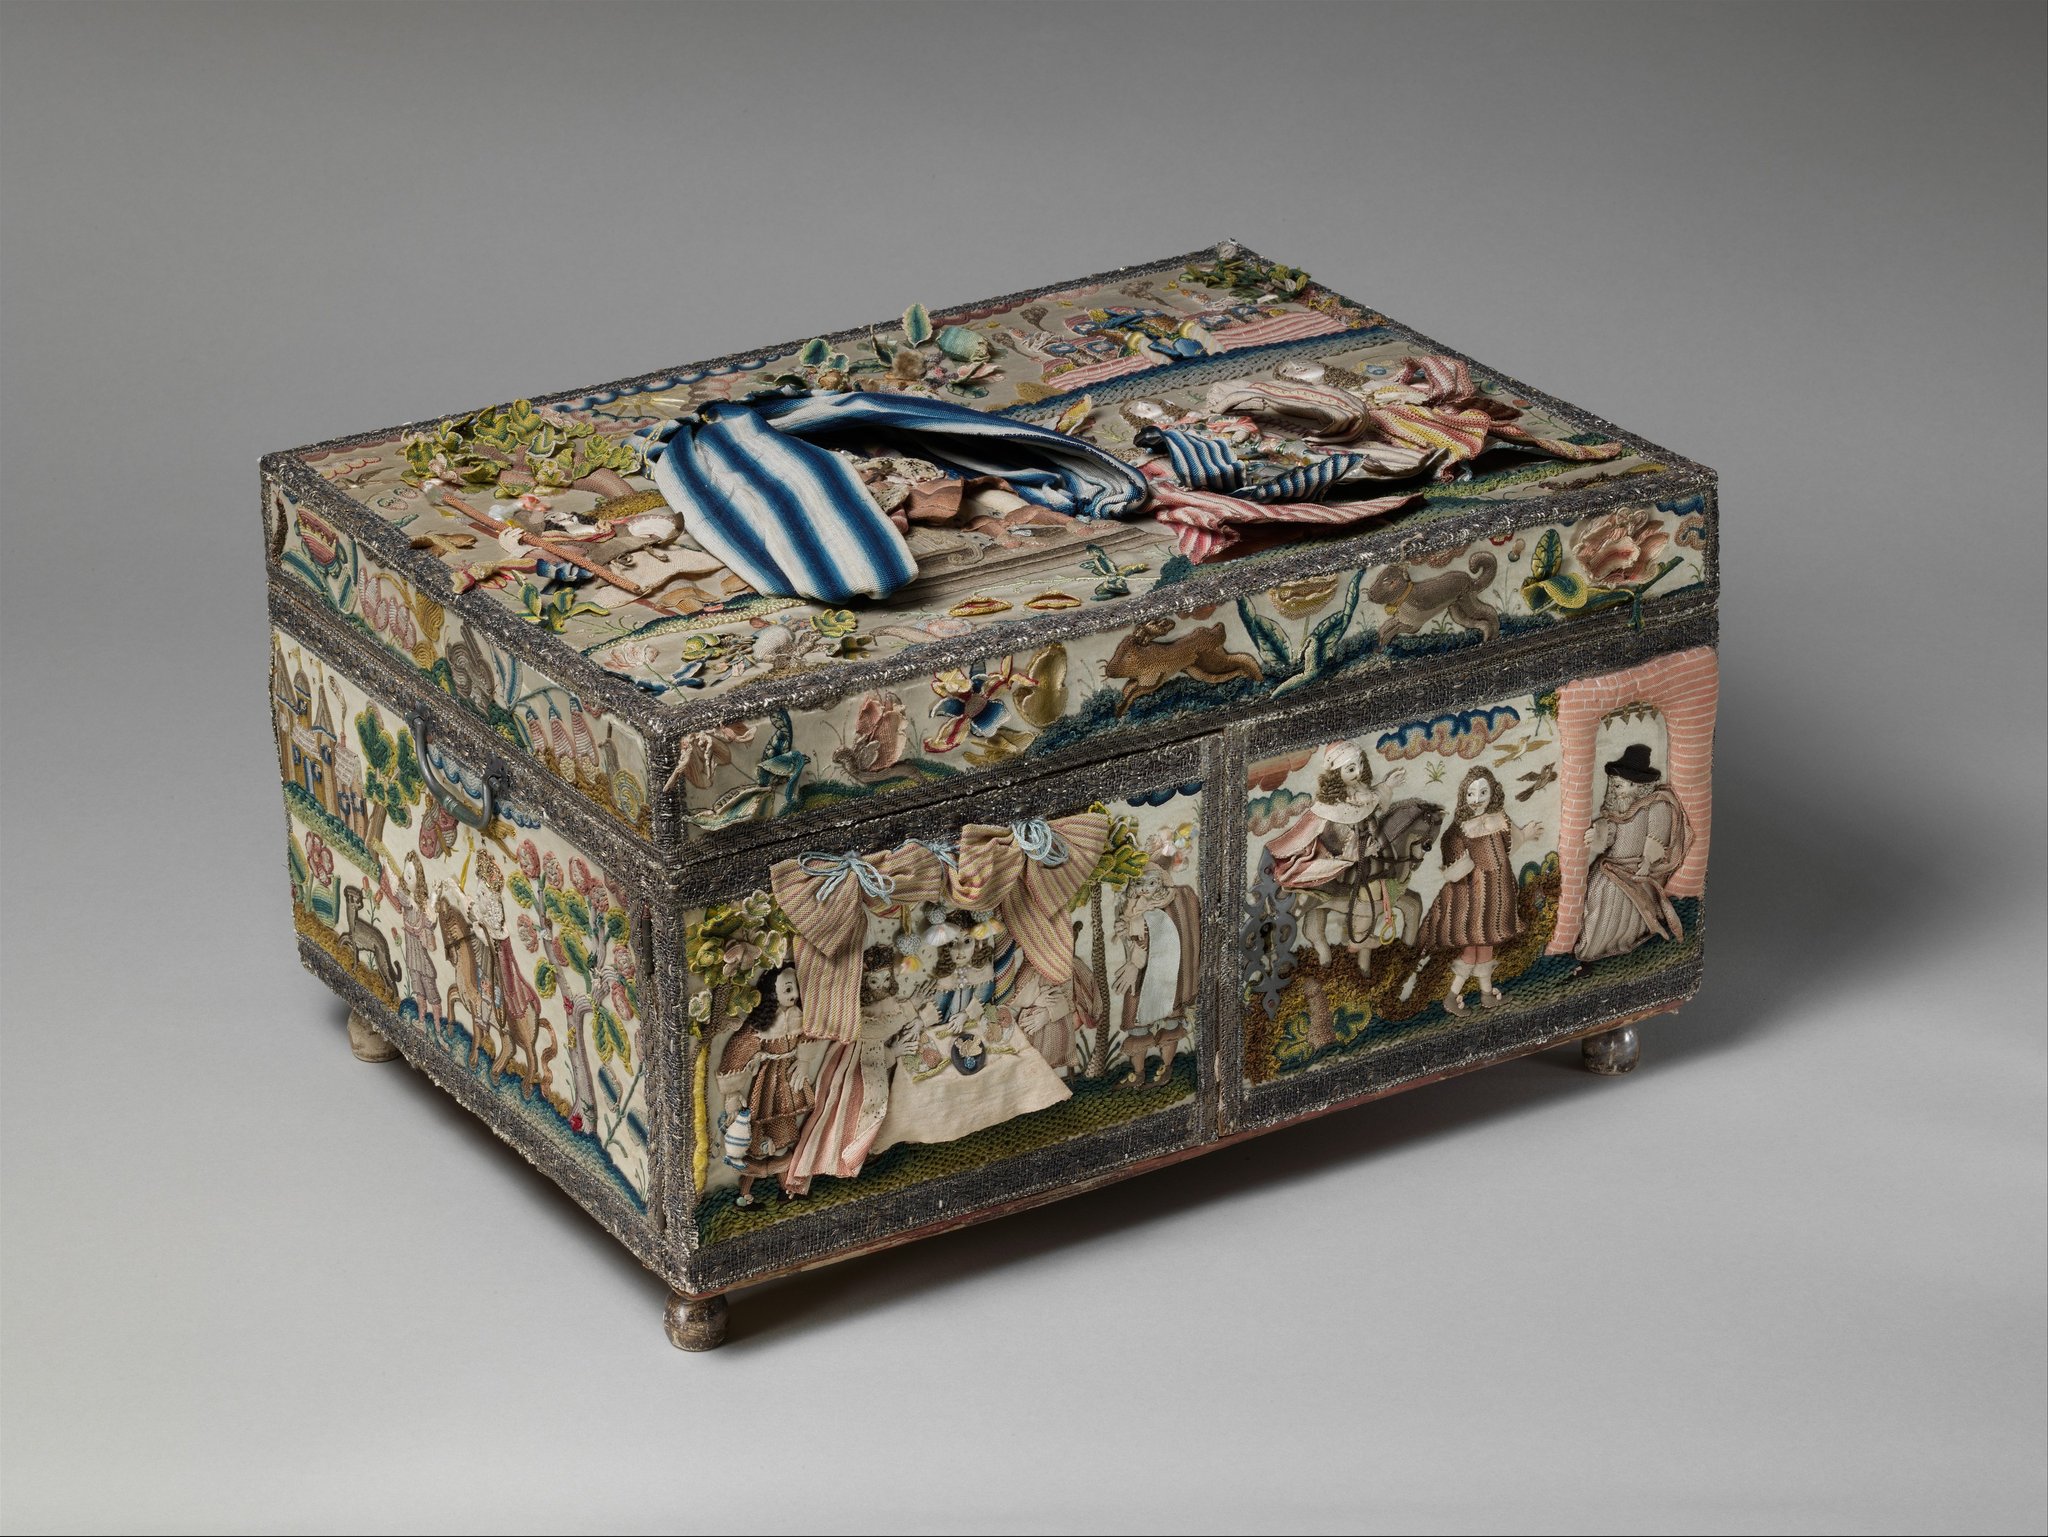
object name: cabinet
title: Cabinet with scenes from the Story of Esther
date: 1665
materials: feather, glass, linen, metal thread, mica, paper, pearl, textile, silk, thread, wood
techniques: embroidery, laid work, lining, printing, stitching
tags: animals,women,horses,insects,butterflies,esther,dining